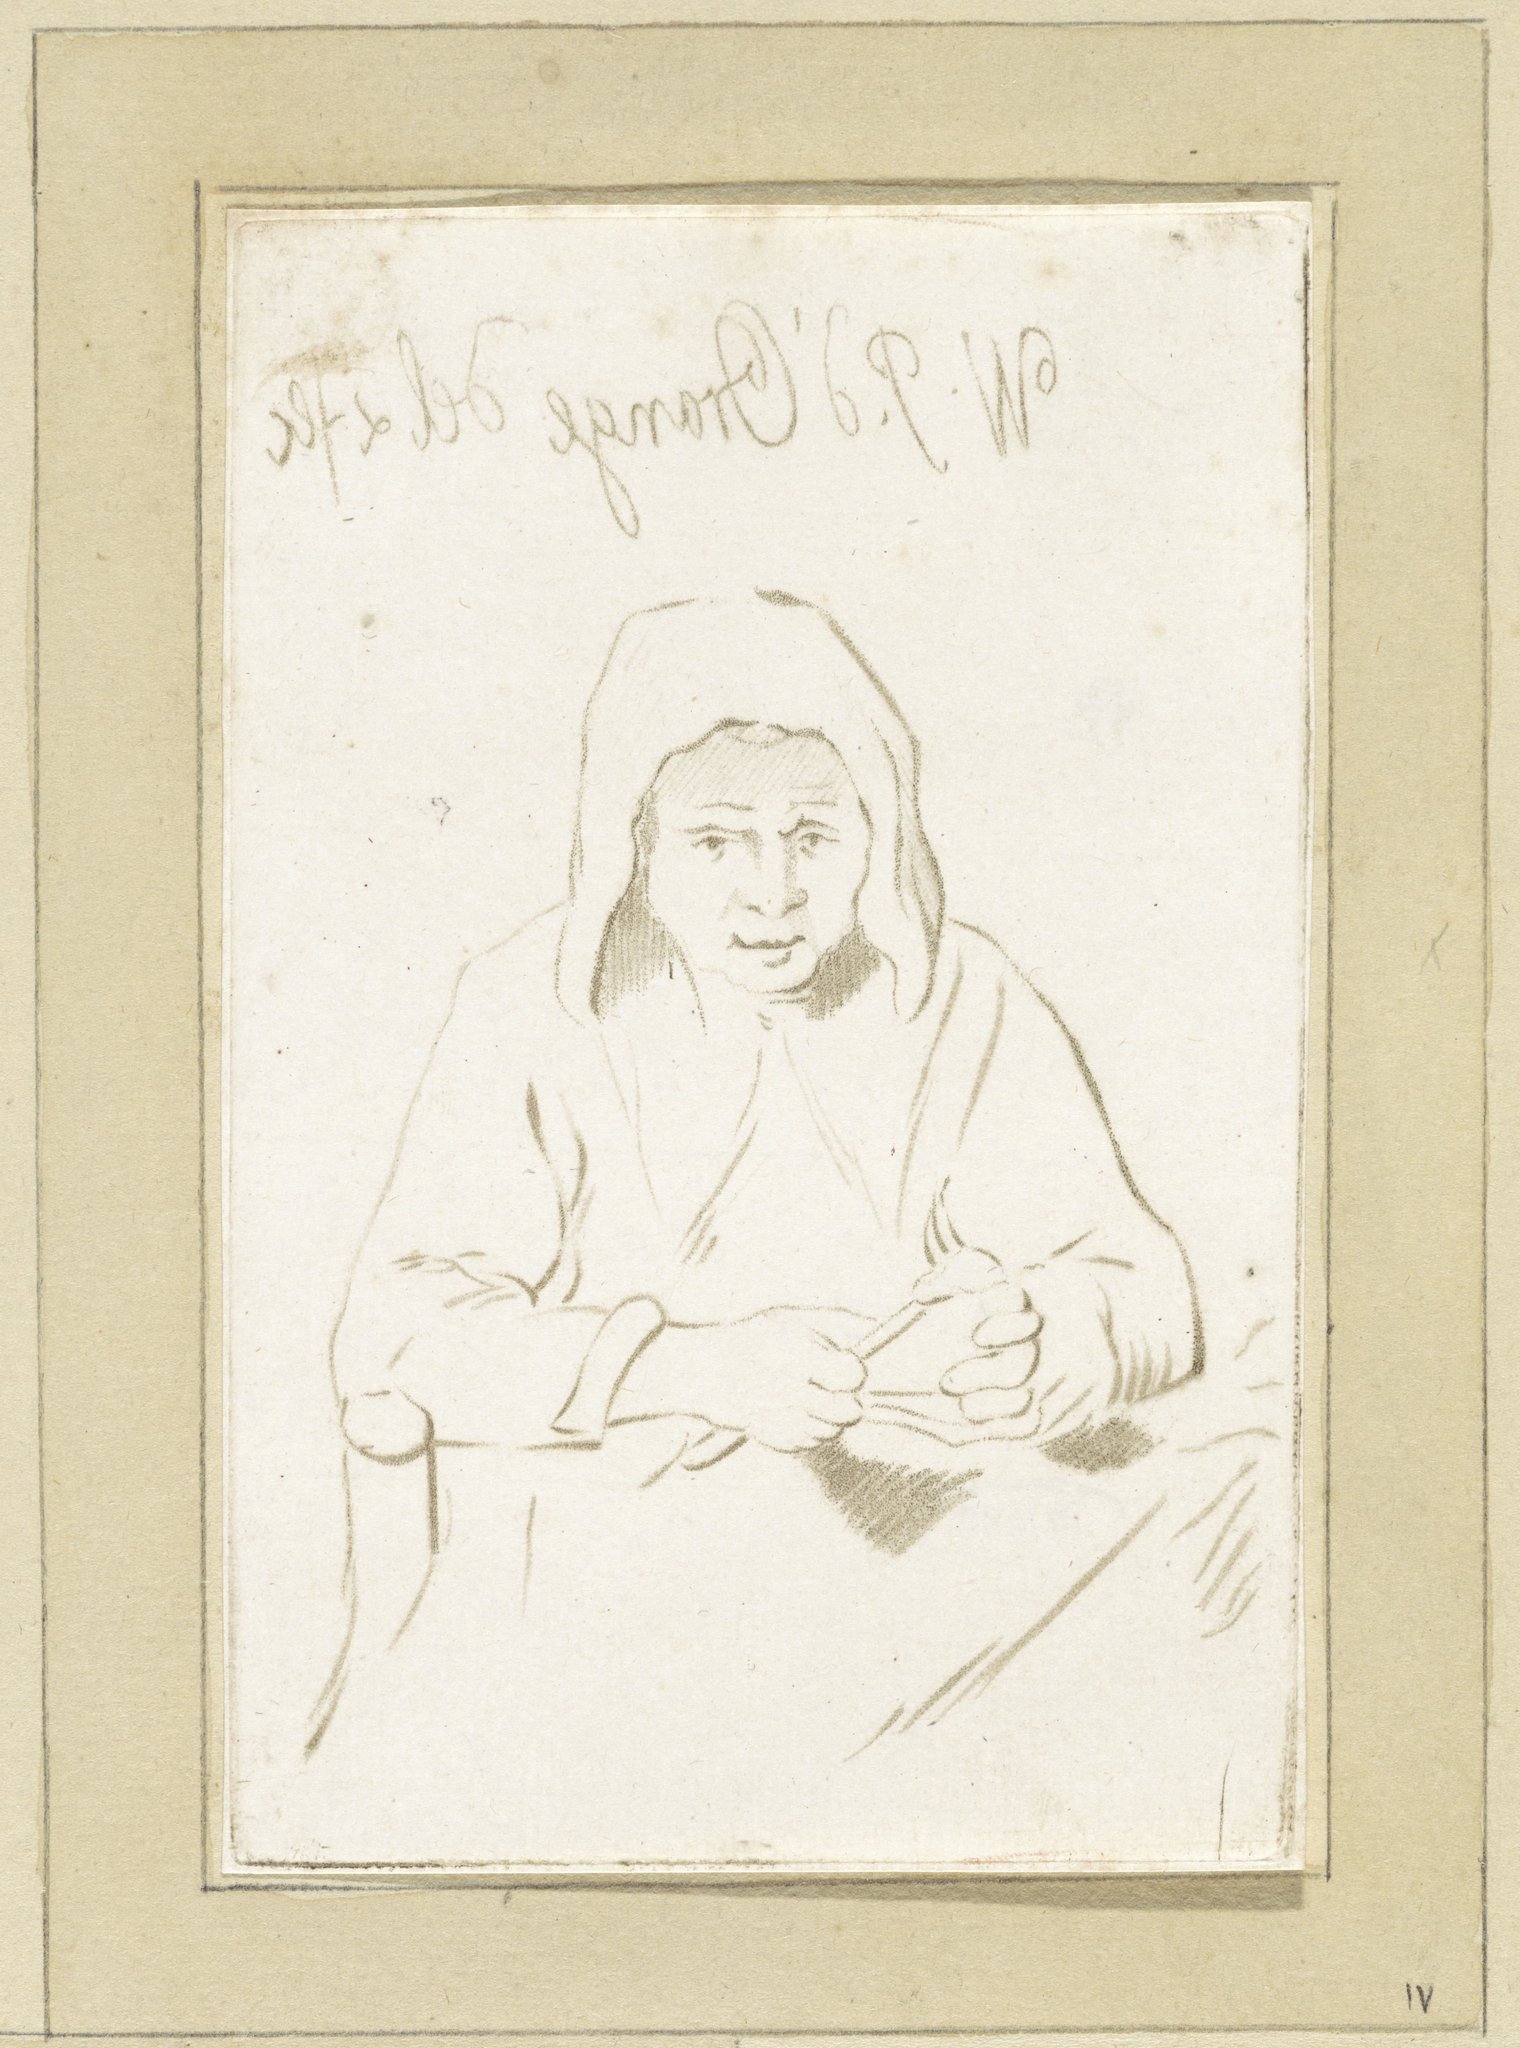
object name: print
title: Zittende oude vrouw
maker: william v (prince of orange)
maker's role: stadhouder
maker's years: 1748-1806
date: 1773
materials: paper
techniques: aquatint, printmaking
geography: the hague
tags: old woman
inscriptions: collector's mark: Lugt 2228, collector's mark: Lugt 2760